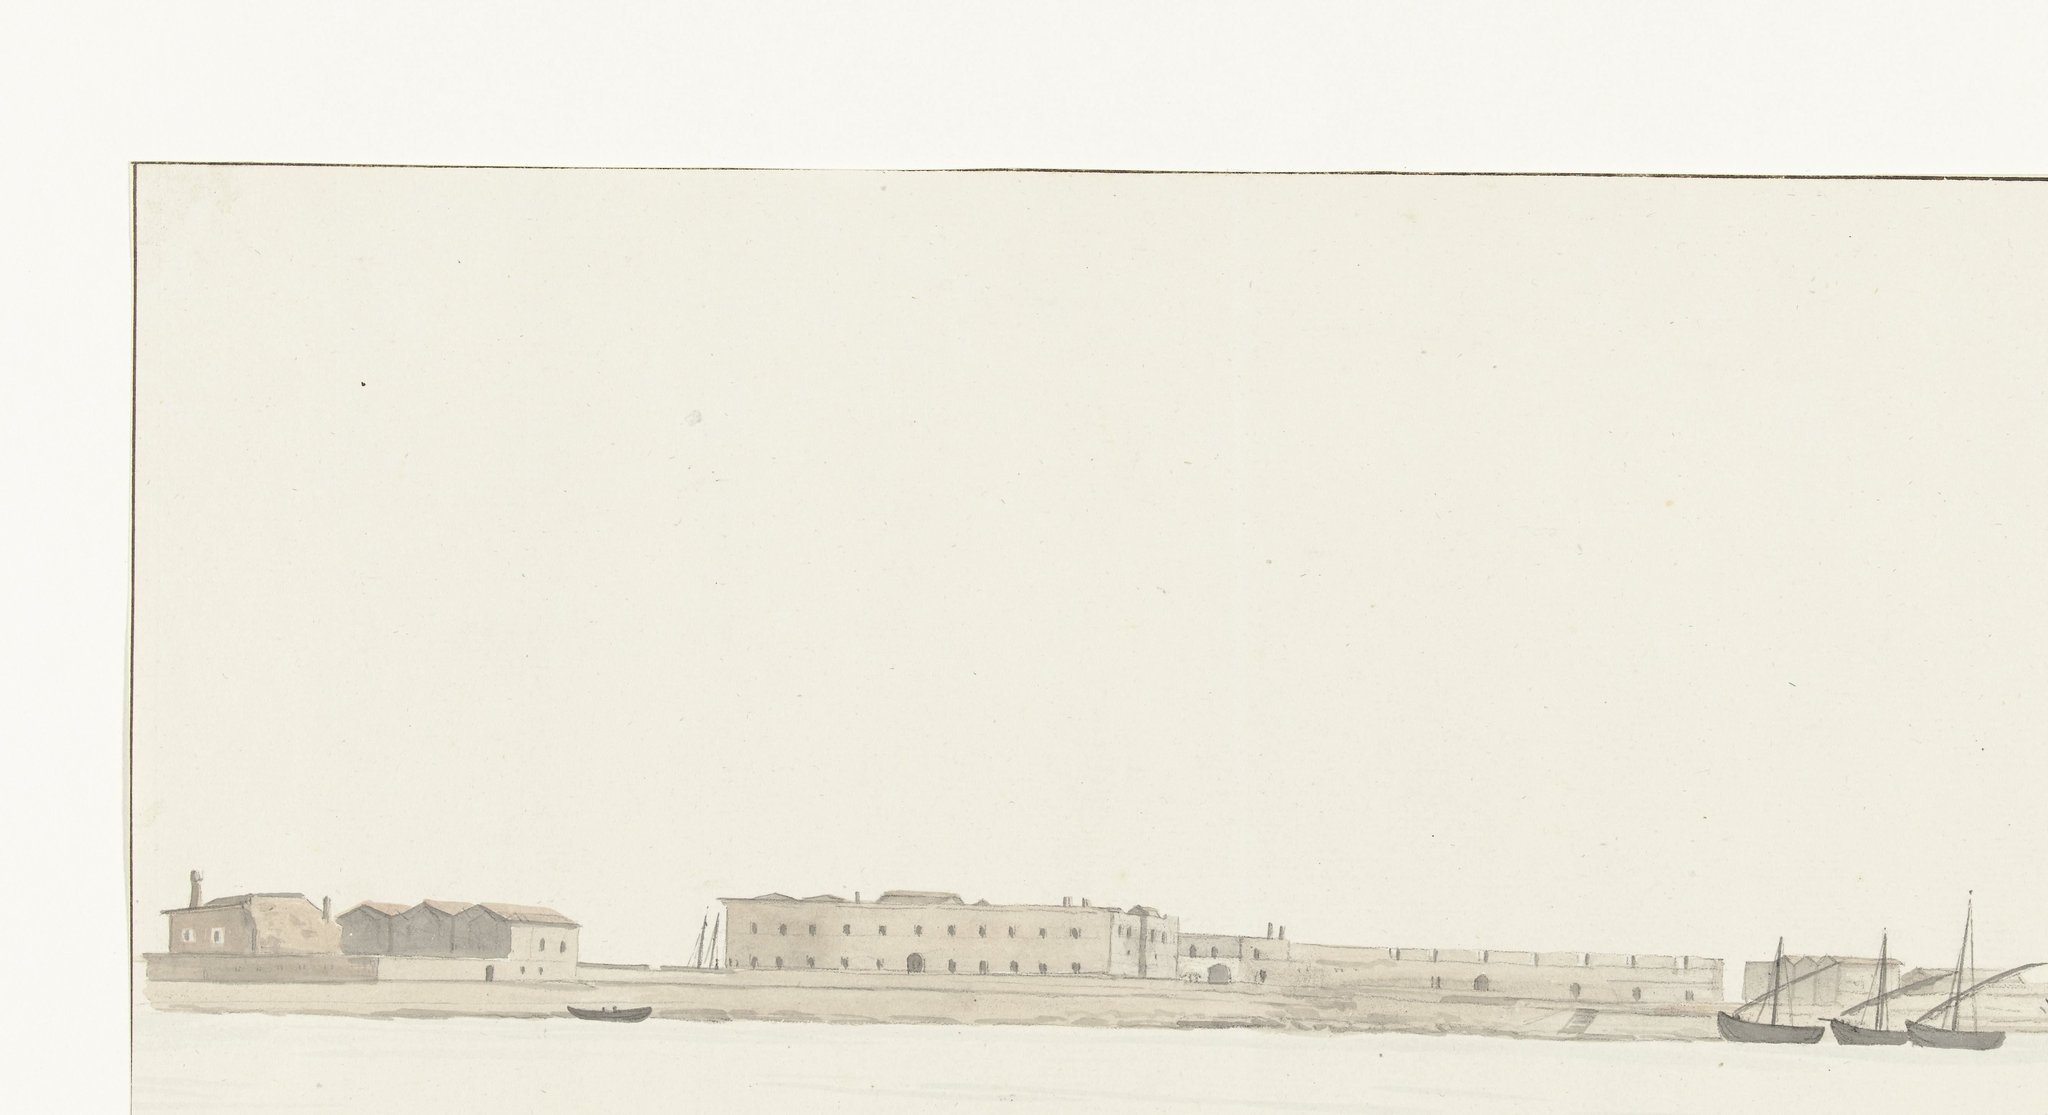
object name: drawing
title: Gezicht op de haven van Trani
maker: louis ducros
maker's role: draughtsman, print maker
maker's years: 1748-1810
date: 1778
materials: paper, watercolor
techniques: brush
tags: trani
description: Tekening uit het album 'Voyage en Italie, en Sicile et à Malte', 1778.